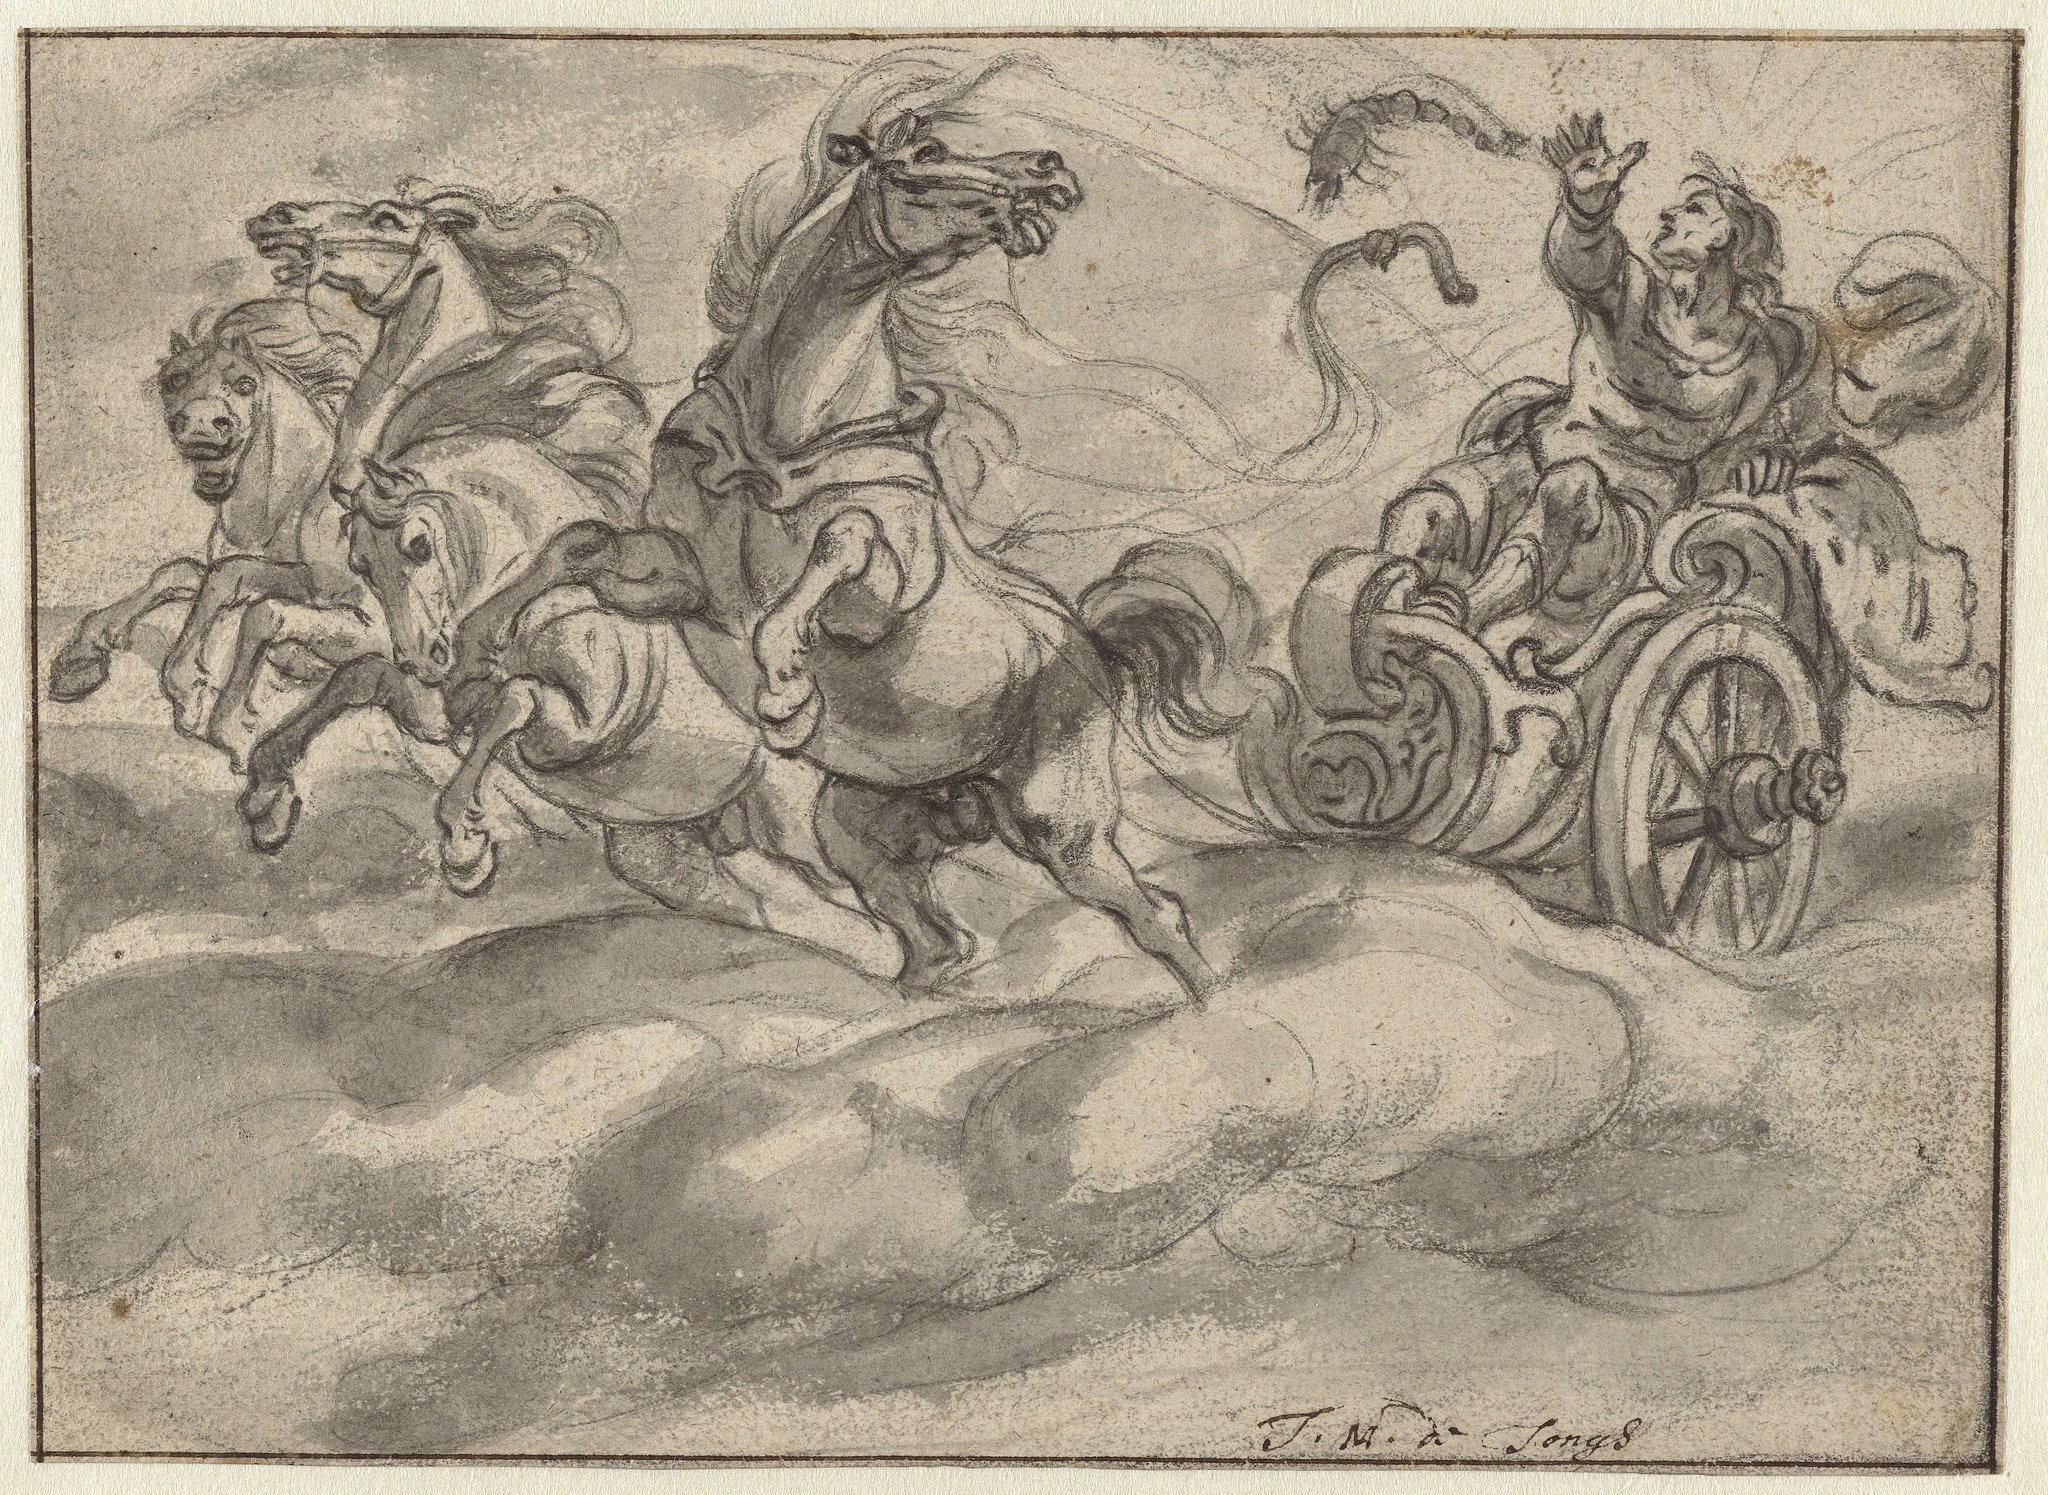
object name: design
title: Phaeton op de zonnewagen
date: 1649-1687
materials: chalk, paper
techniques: brush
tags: phaethon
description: Phaeton met het teken van de Schorpioen. Ontwerp voor een prent.